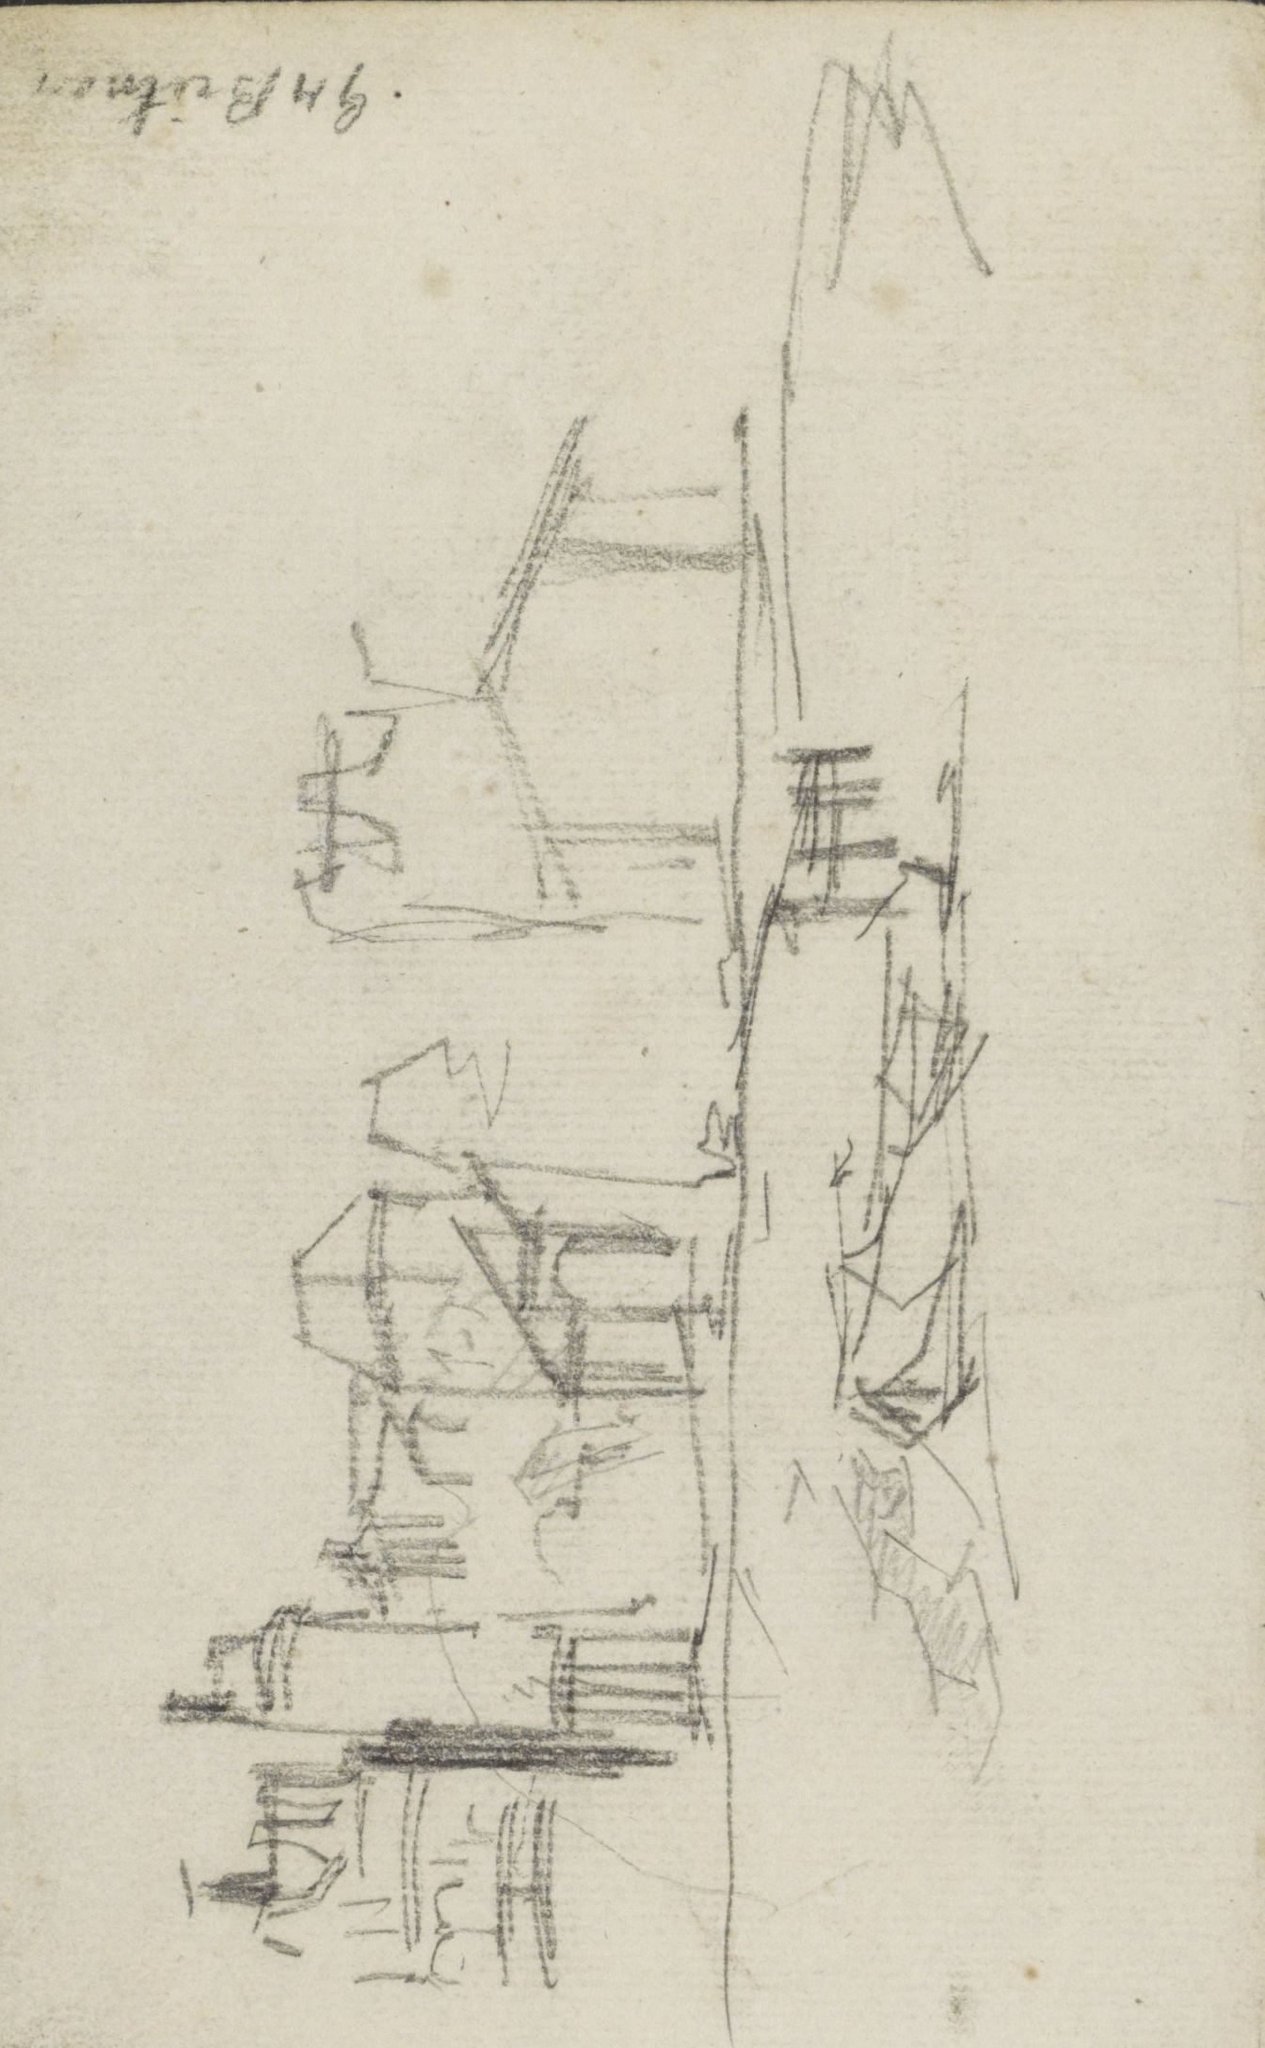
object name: drawing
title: Mannenhoofd en een gezicht in Amsterdam met ophaalbruggen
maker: george hendrik breitner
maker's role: draughtsman, painter, print maker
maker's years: 1857-1923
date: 1886-1923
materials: chalk, paper, pencil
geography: amsterdam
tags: head (human), bridge in city across river, canal, etc., amsterdam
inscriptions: signature: ‘G H Breitner’